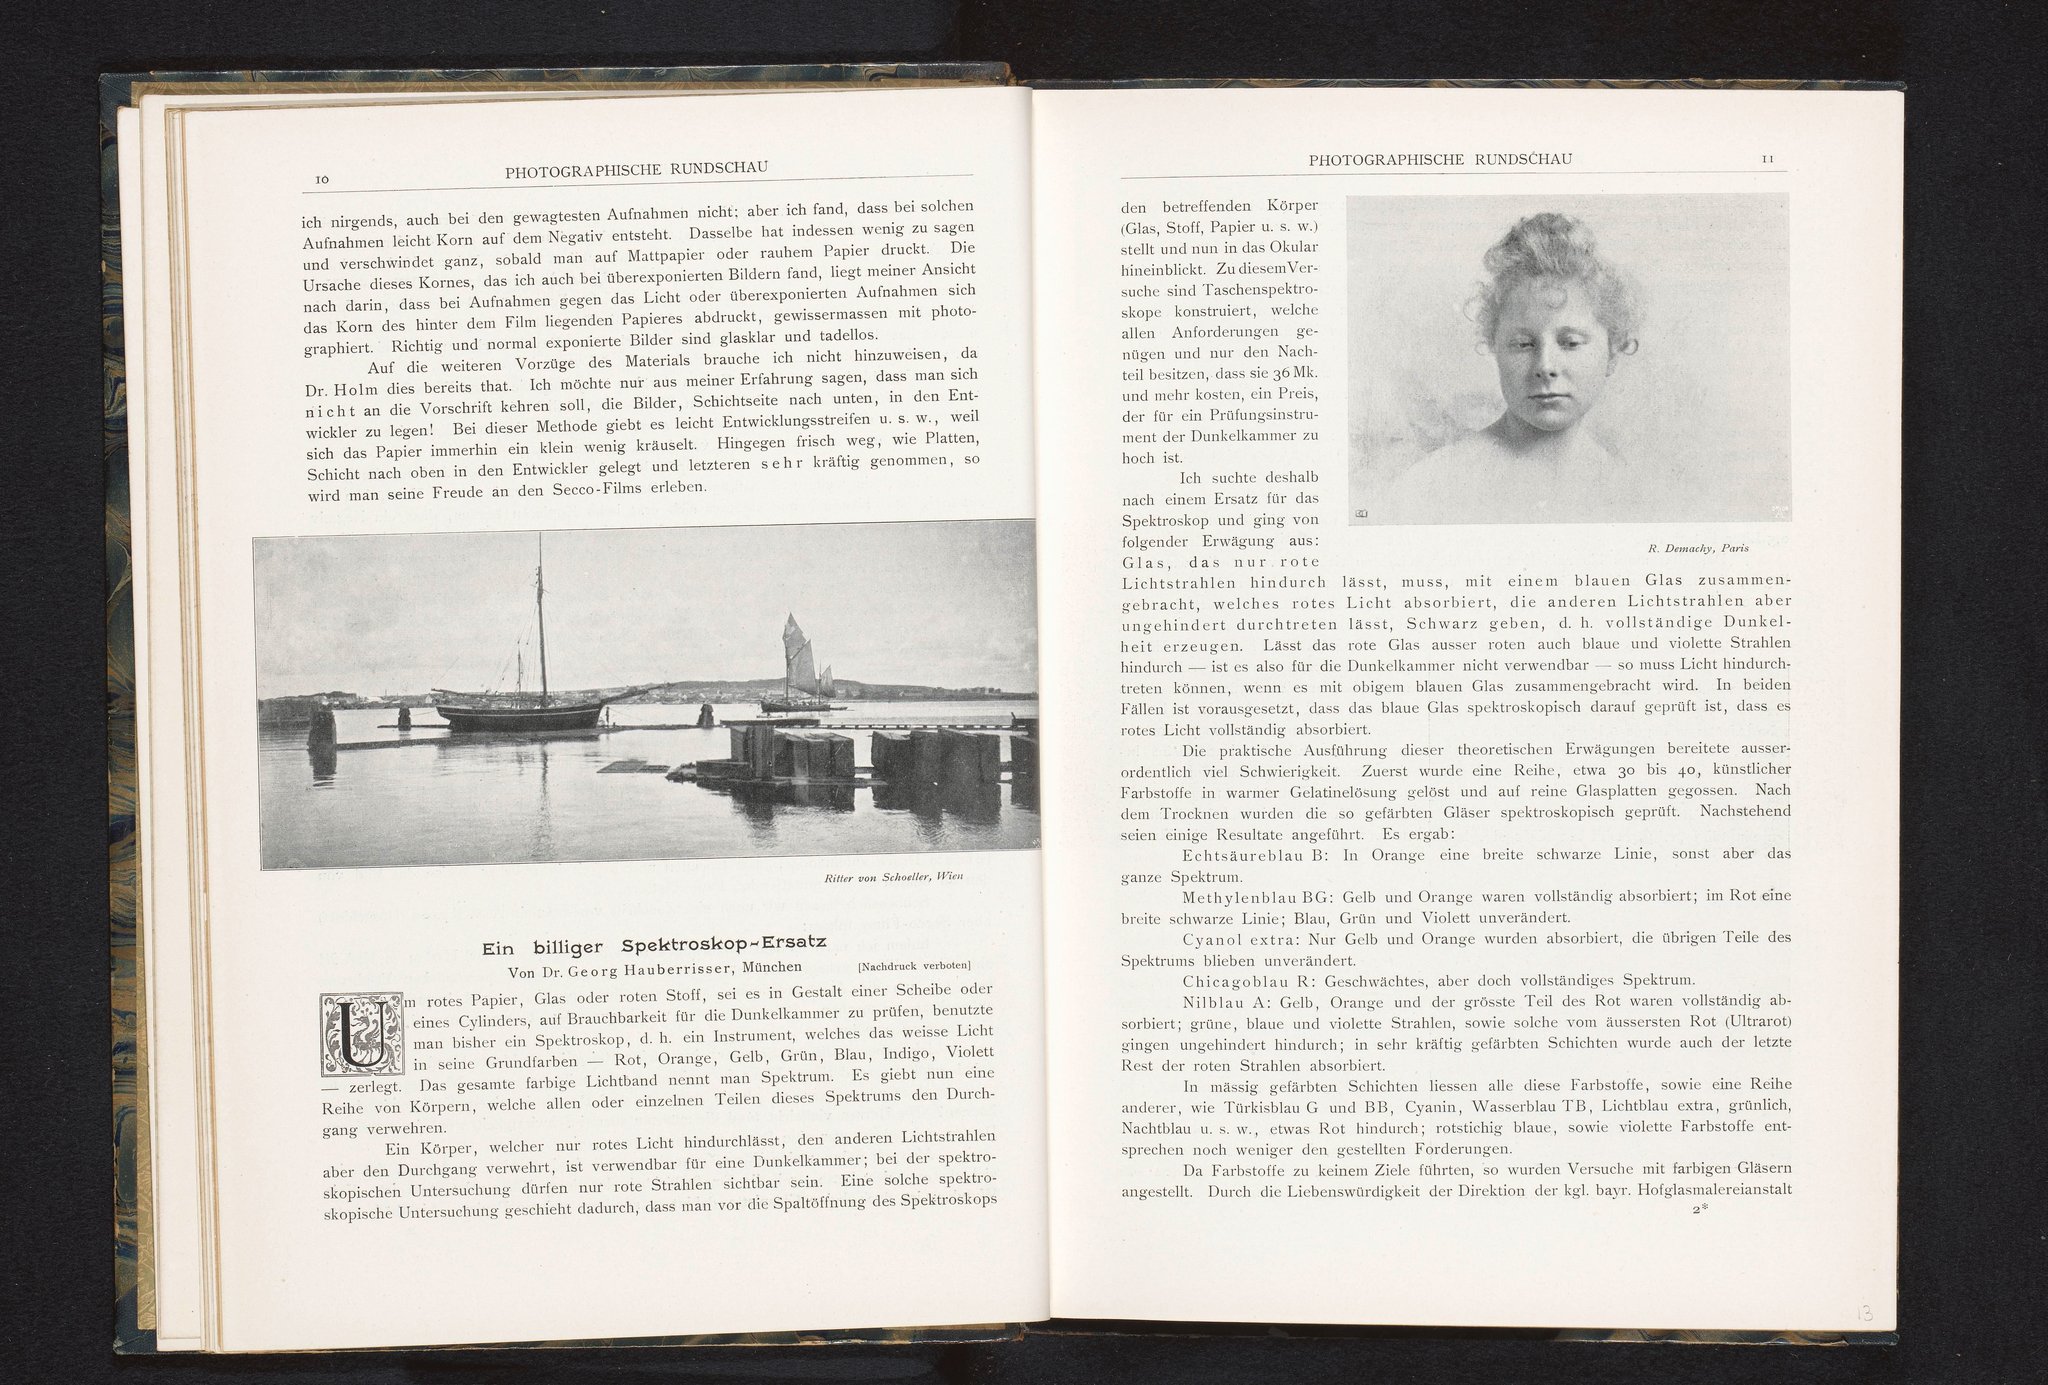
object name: reproduction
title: Fotoreproductie van een portret van een jonge vrouw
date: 1895-1900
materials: paper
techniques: autotype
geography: paris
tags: drawing, sketch, adolescent, young woman, maiden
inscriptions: monogram: ‘drAco’